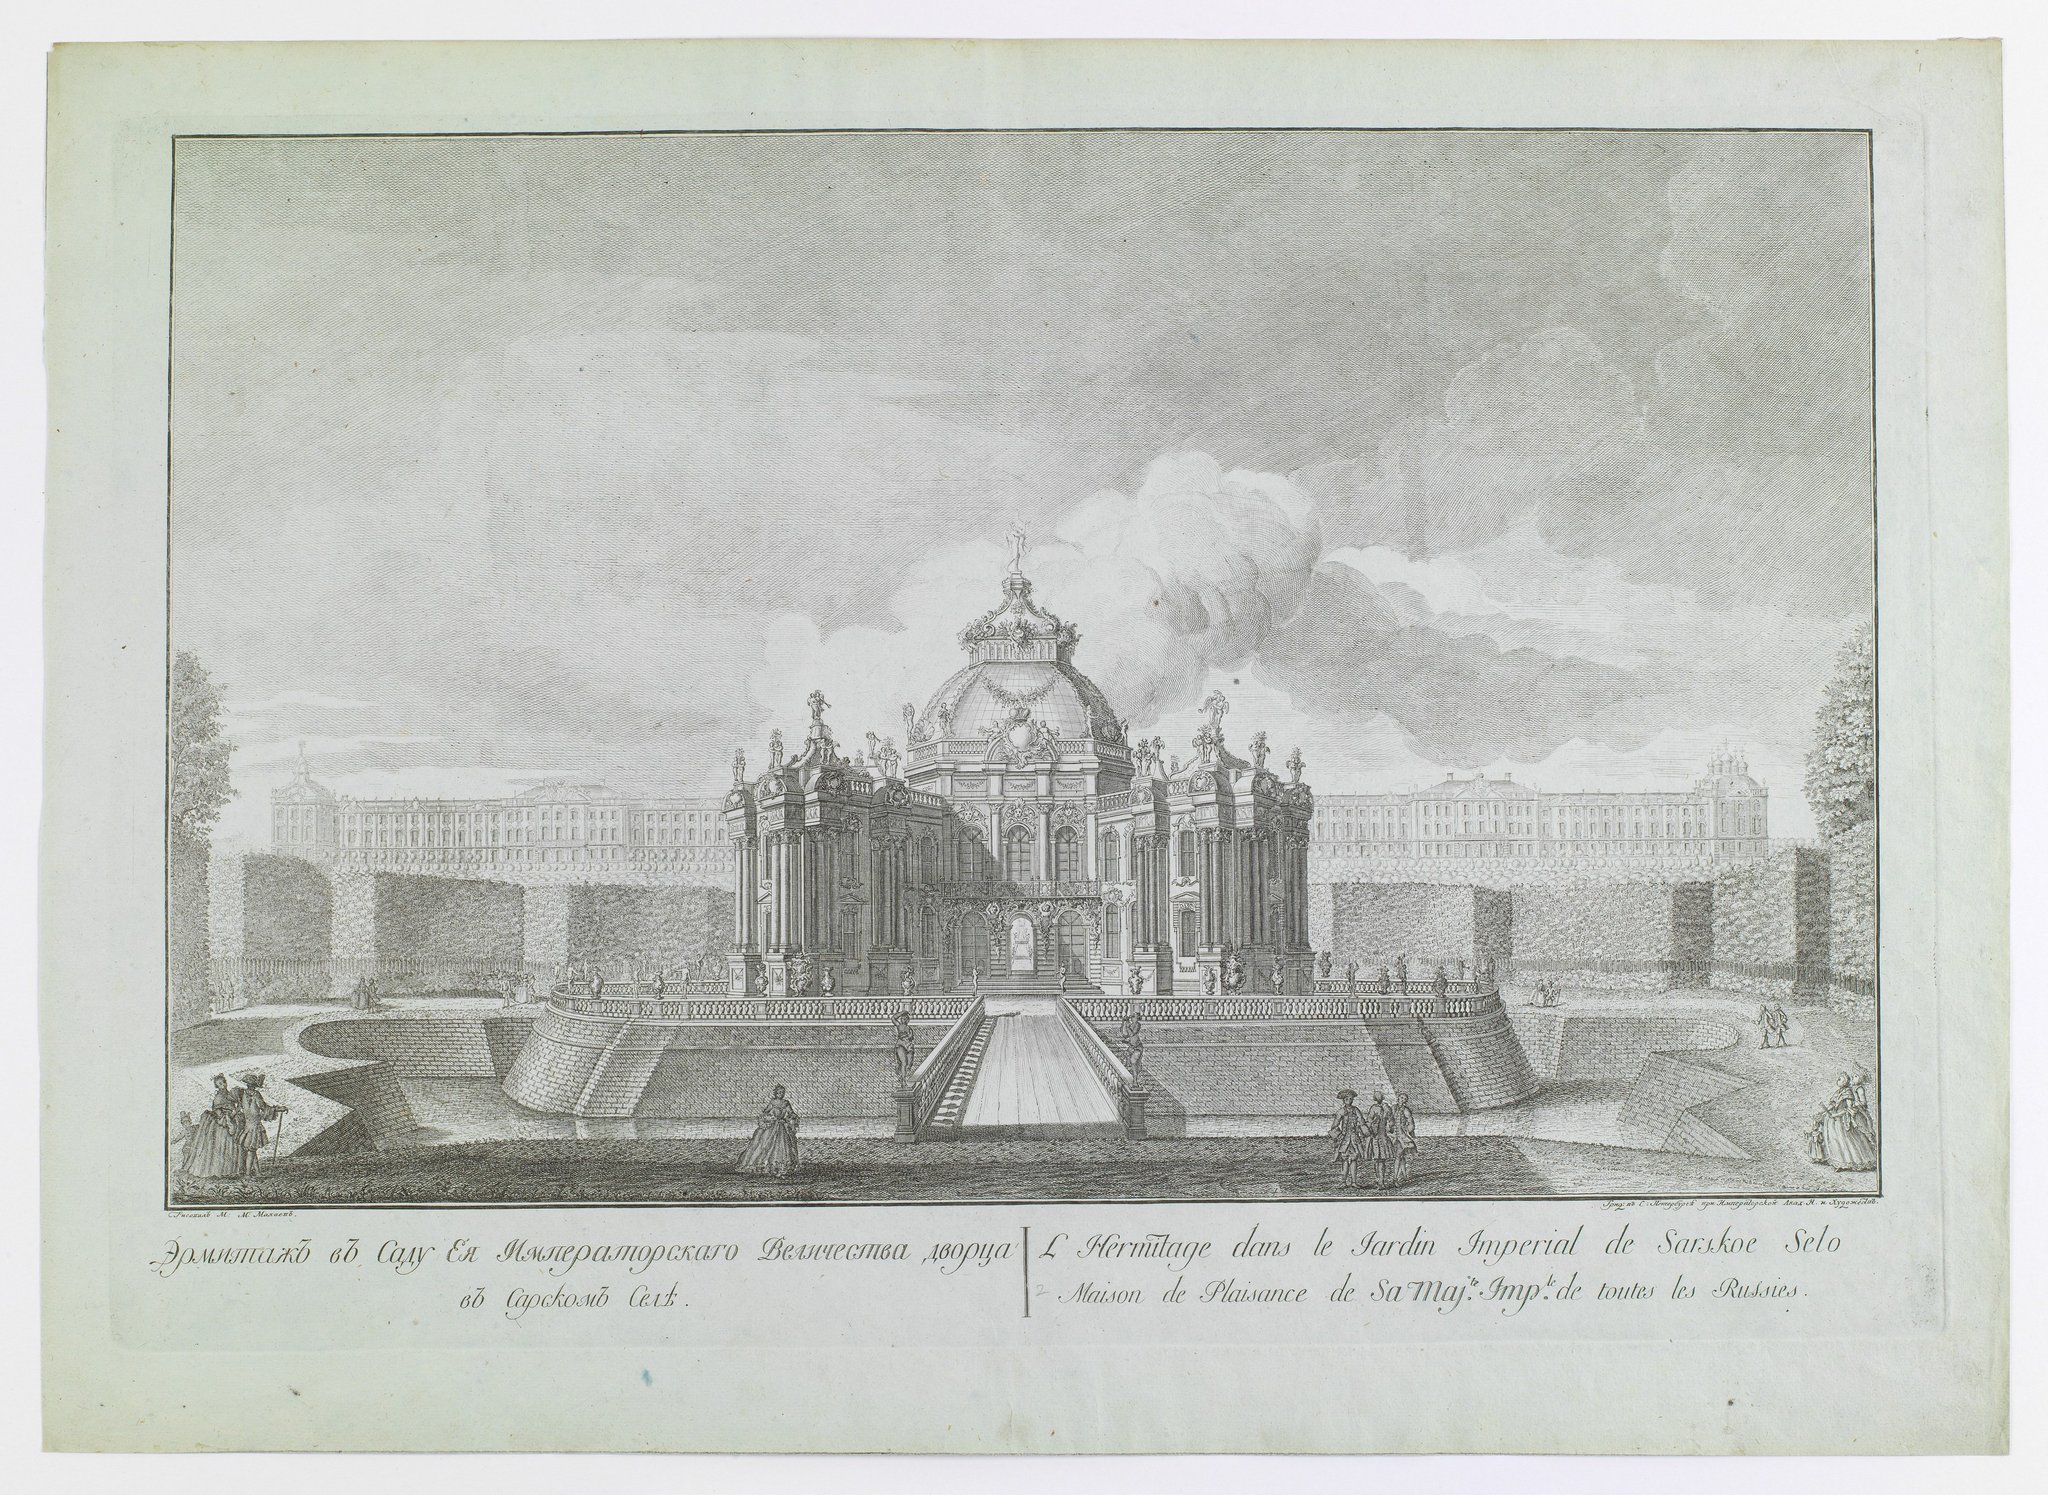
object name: portfolio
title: Russian Palaces and Gardens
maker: mikhail makhaev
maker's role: artist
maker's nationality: russian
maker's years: 1716-1770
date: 1761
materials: leather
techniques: engraving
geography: russia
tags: human figures,palaces,gardens